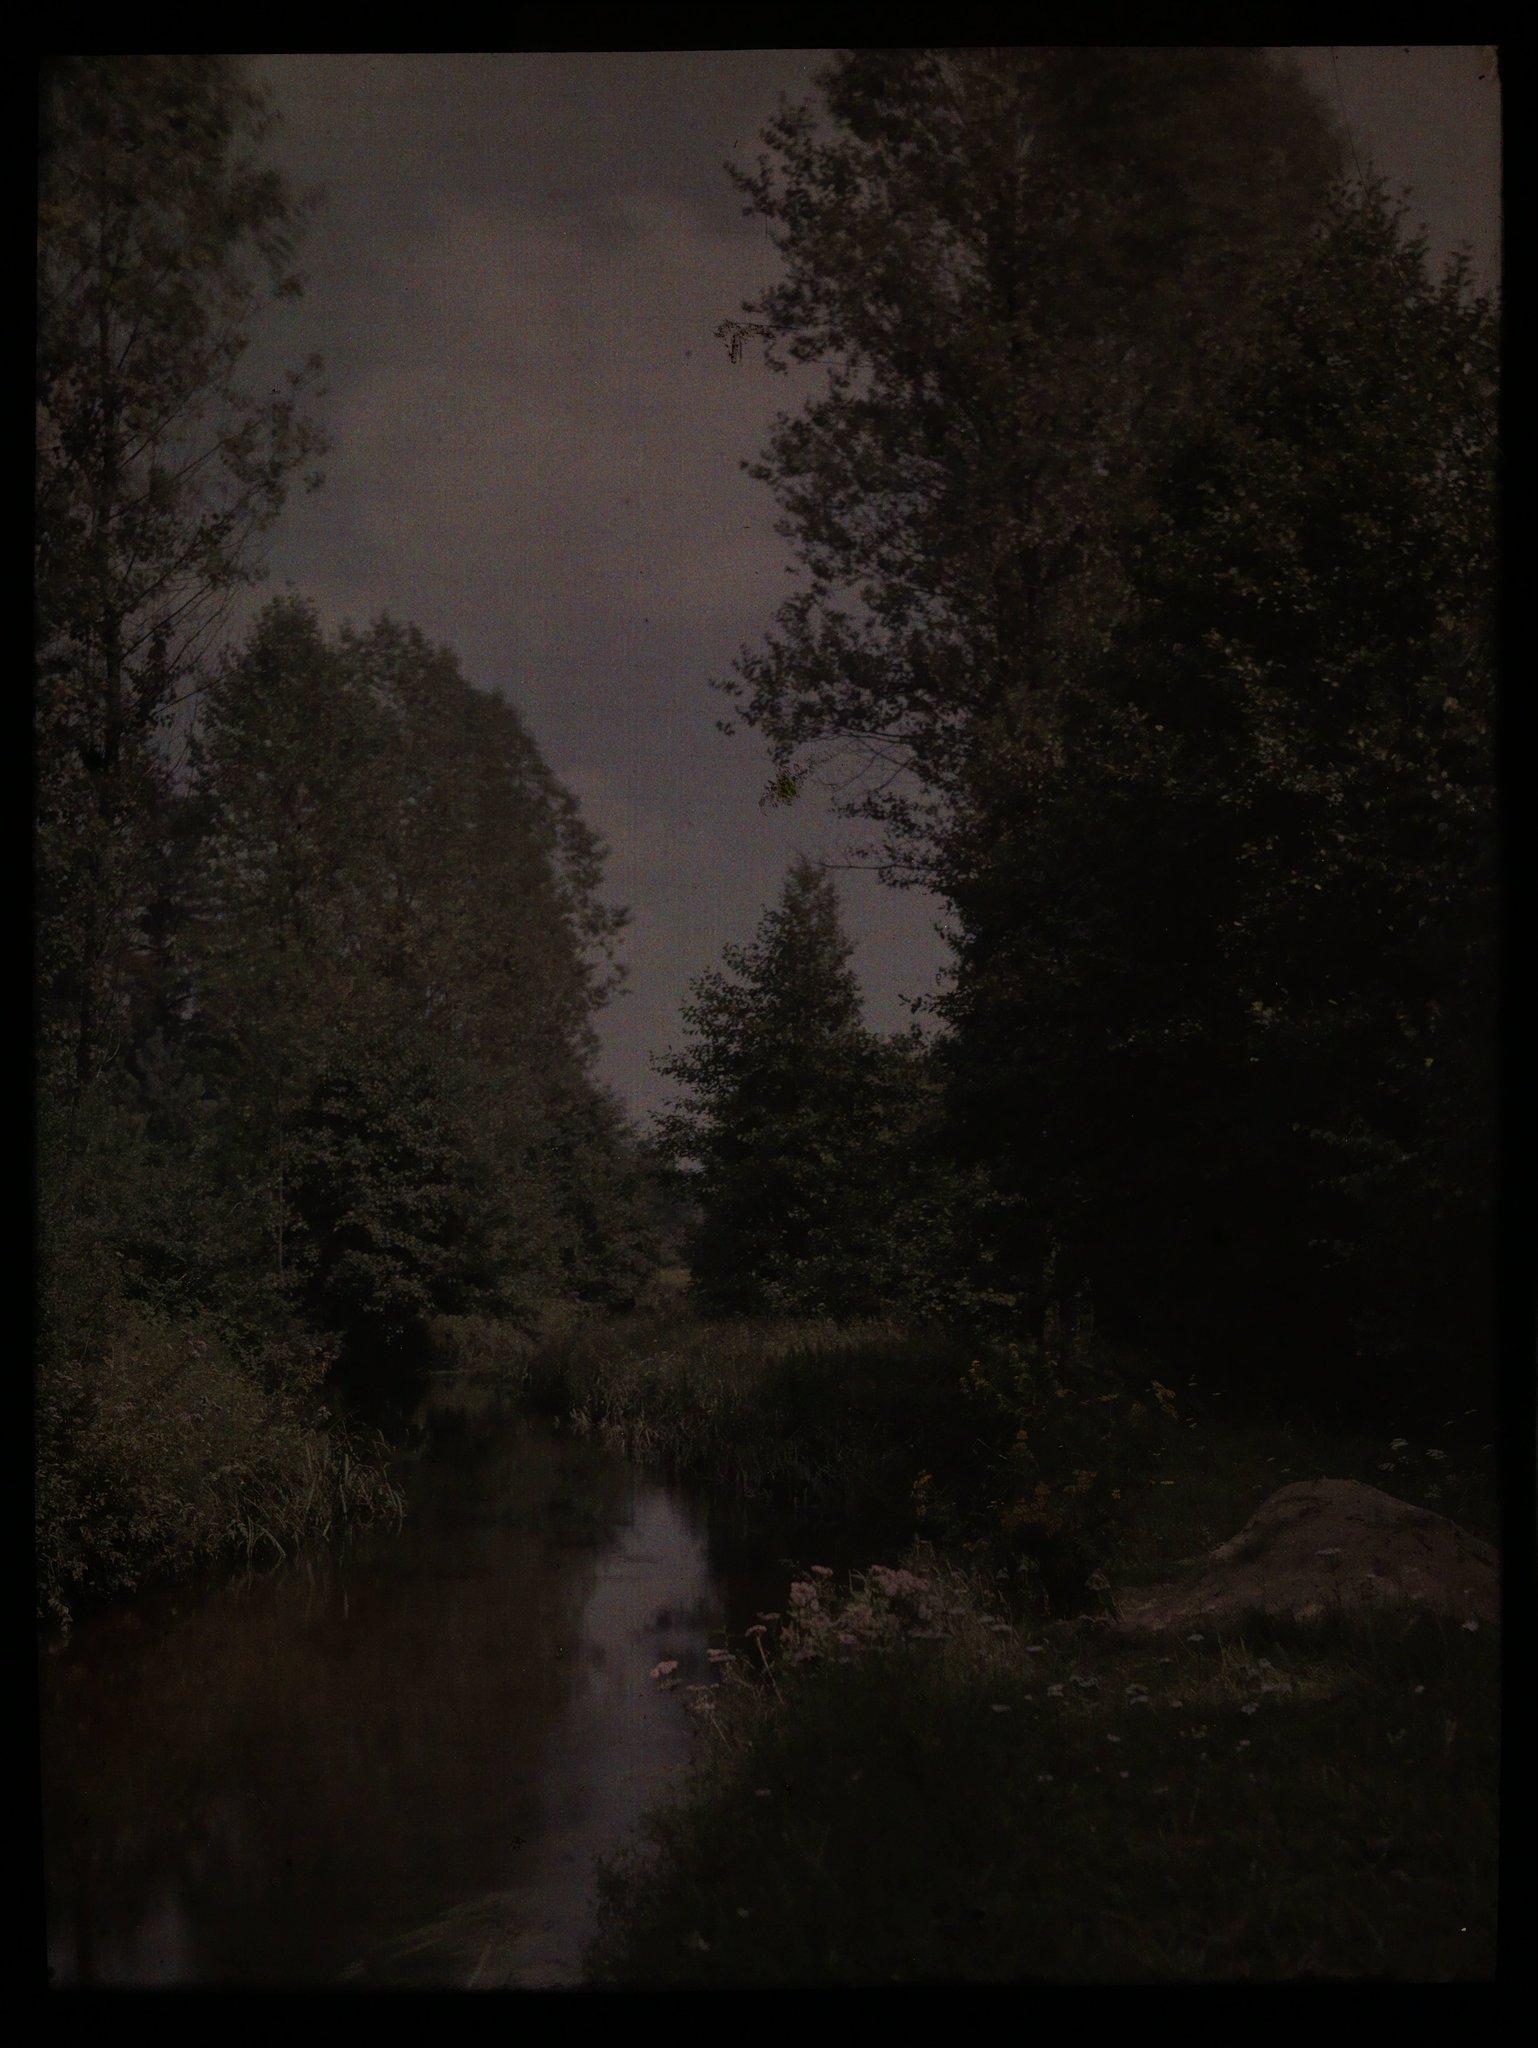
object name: photograph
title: Bos met sloot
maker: Anonymous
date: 1907-1935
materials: glass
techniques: autochrome process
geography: netherlands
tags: forest, wood, netherlands